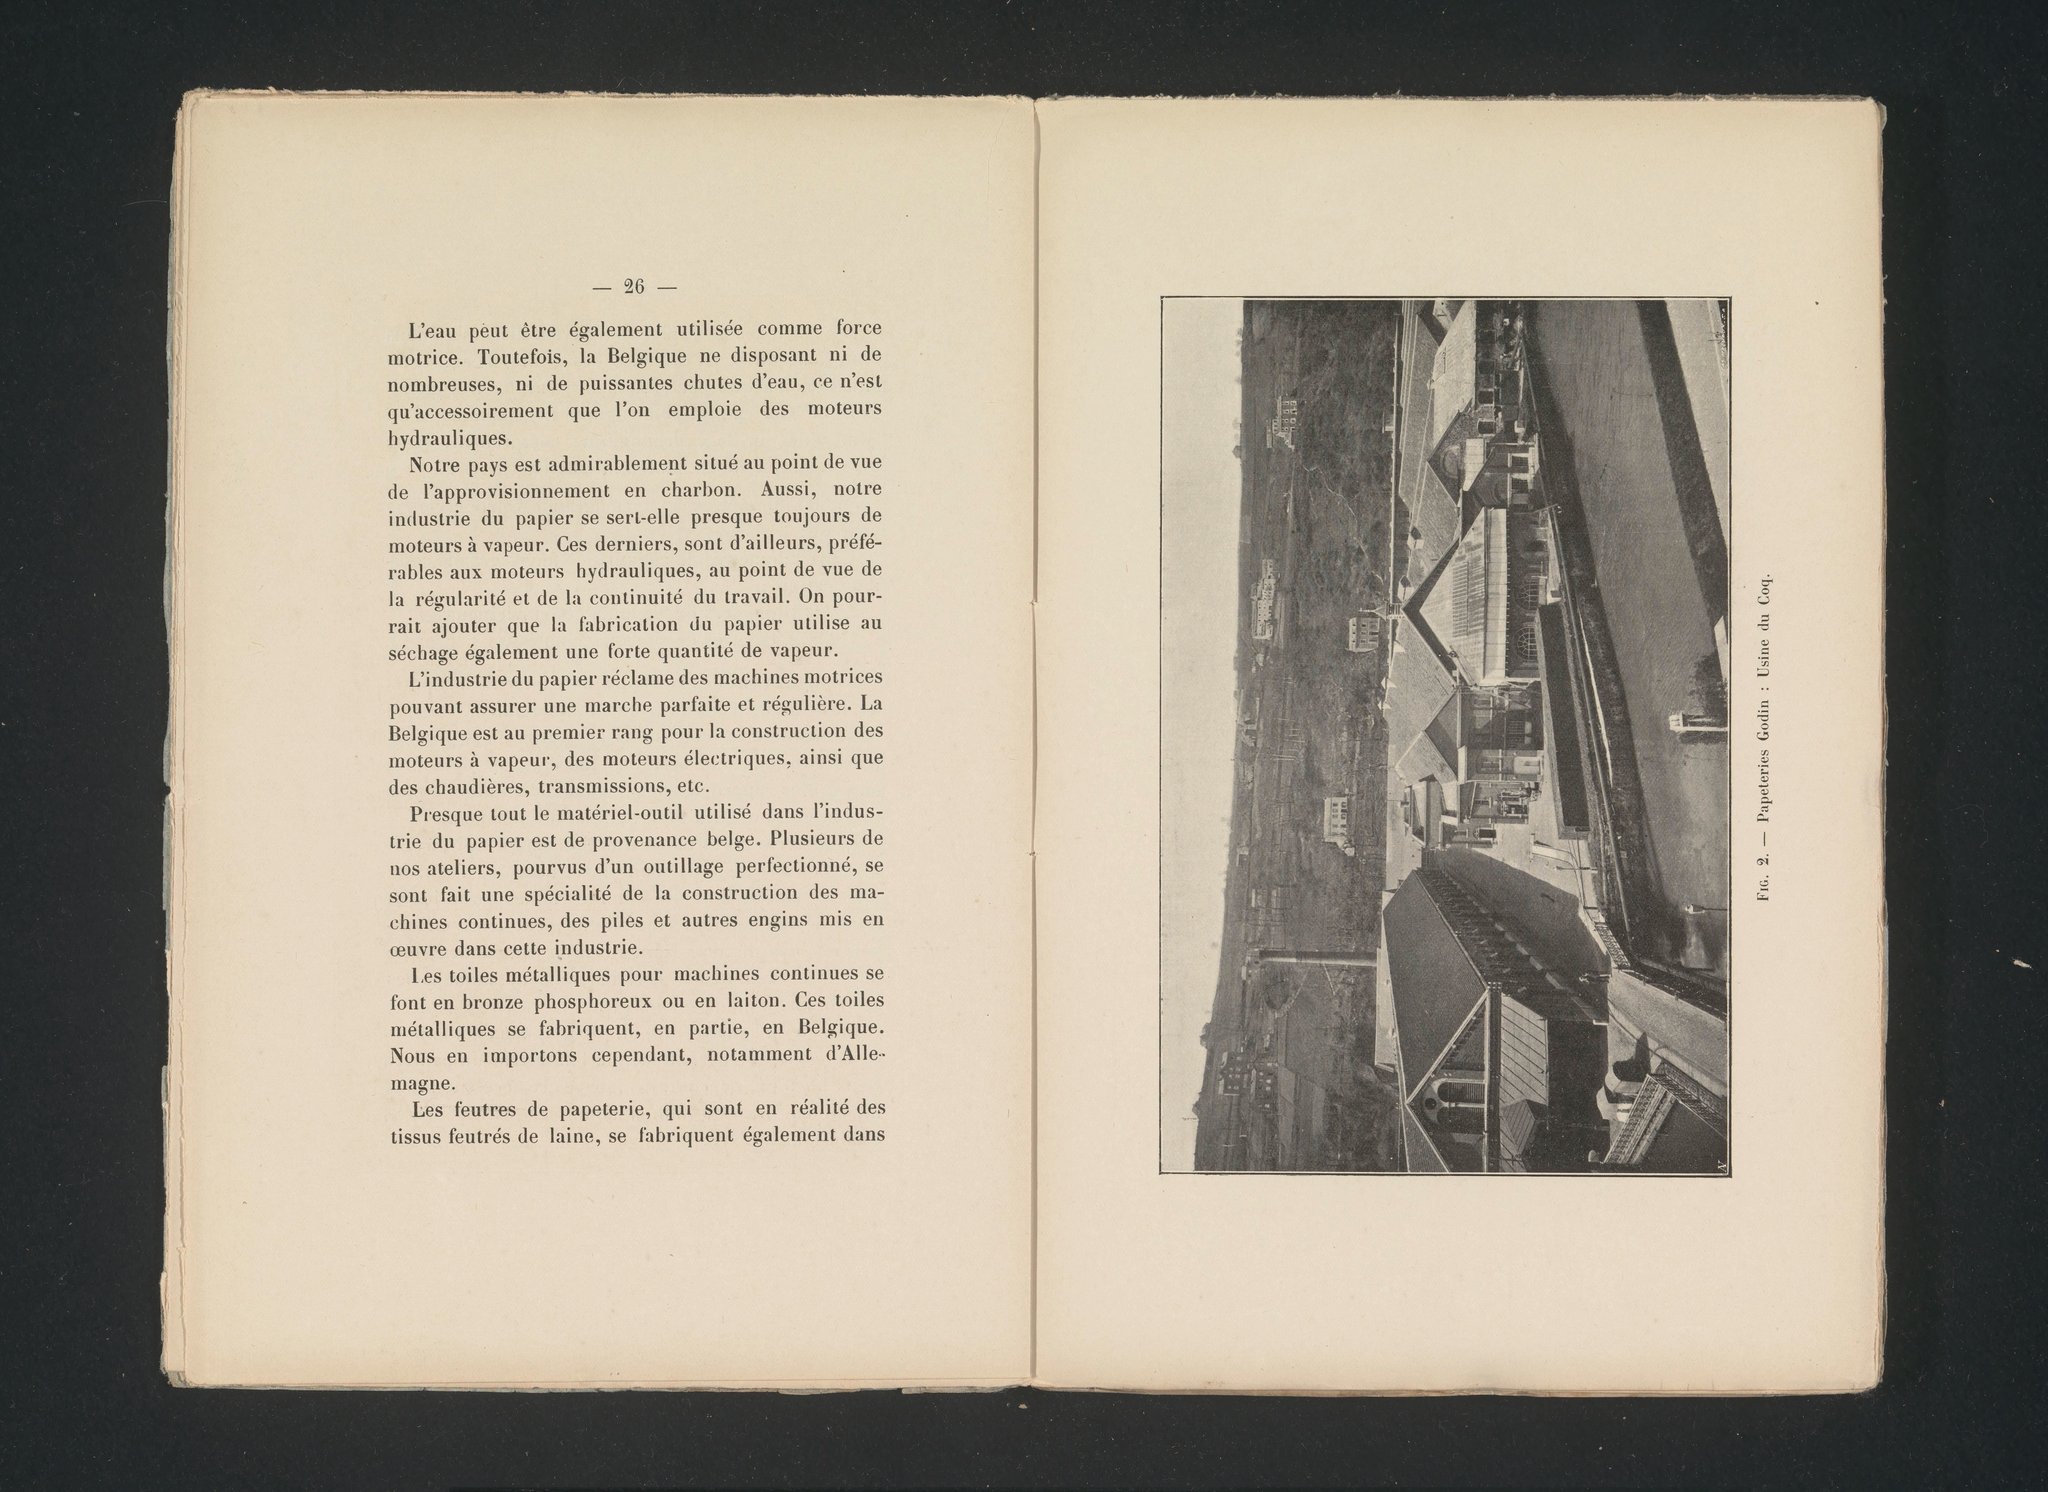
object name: photomechanical print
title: Gezicht op een gebouw van de papierfabriek van Godin in Hoei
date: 1901-1906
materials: paper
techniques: autotype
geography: hoei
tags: factory-building, paper (writing material)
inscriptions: monogram: ‘AN’, inscription: ‘Fig. 2. - Papeteries Godin: Usine du Coq’